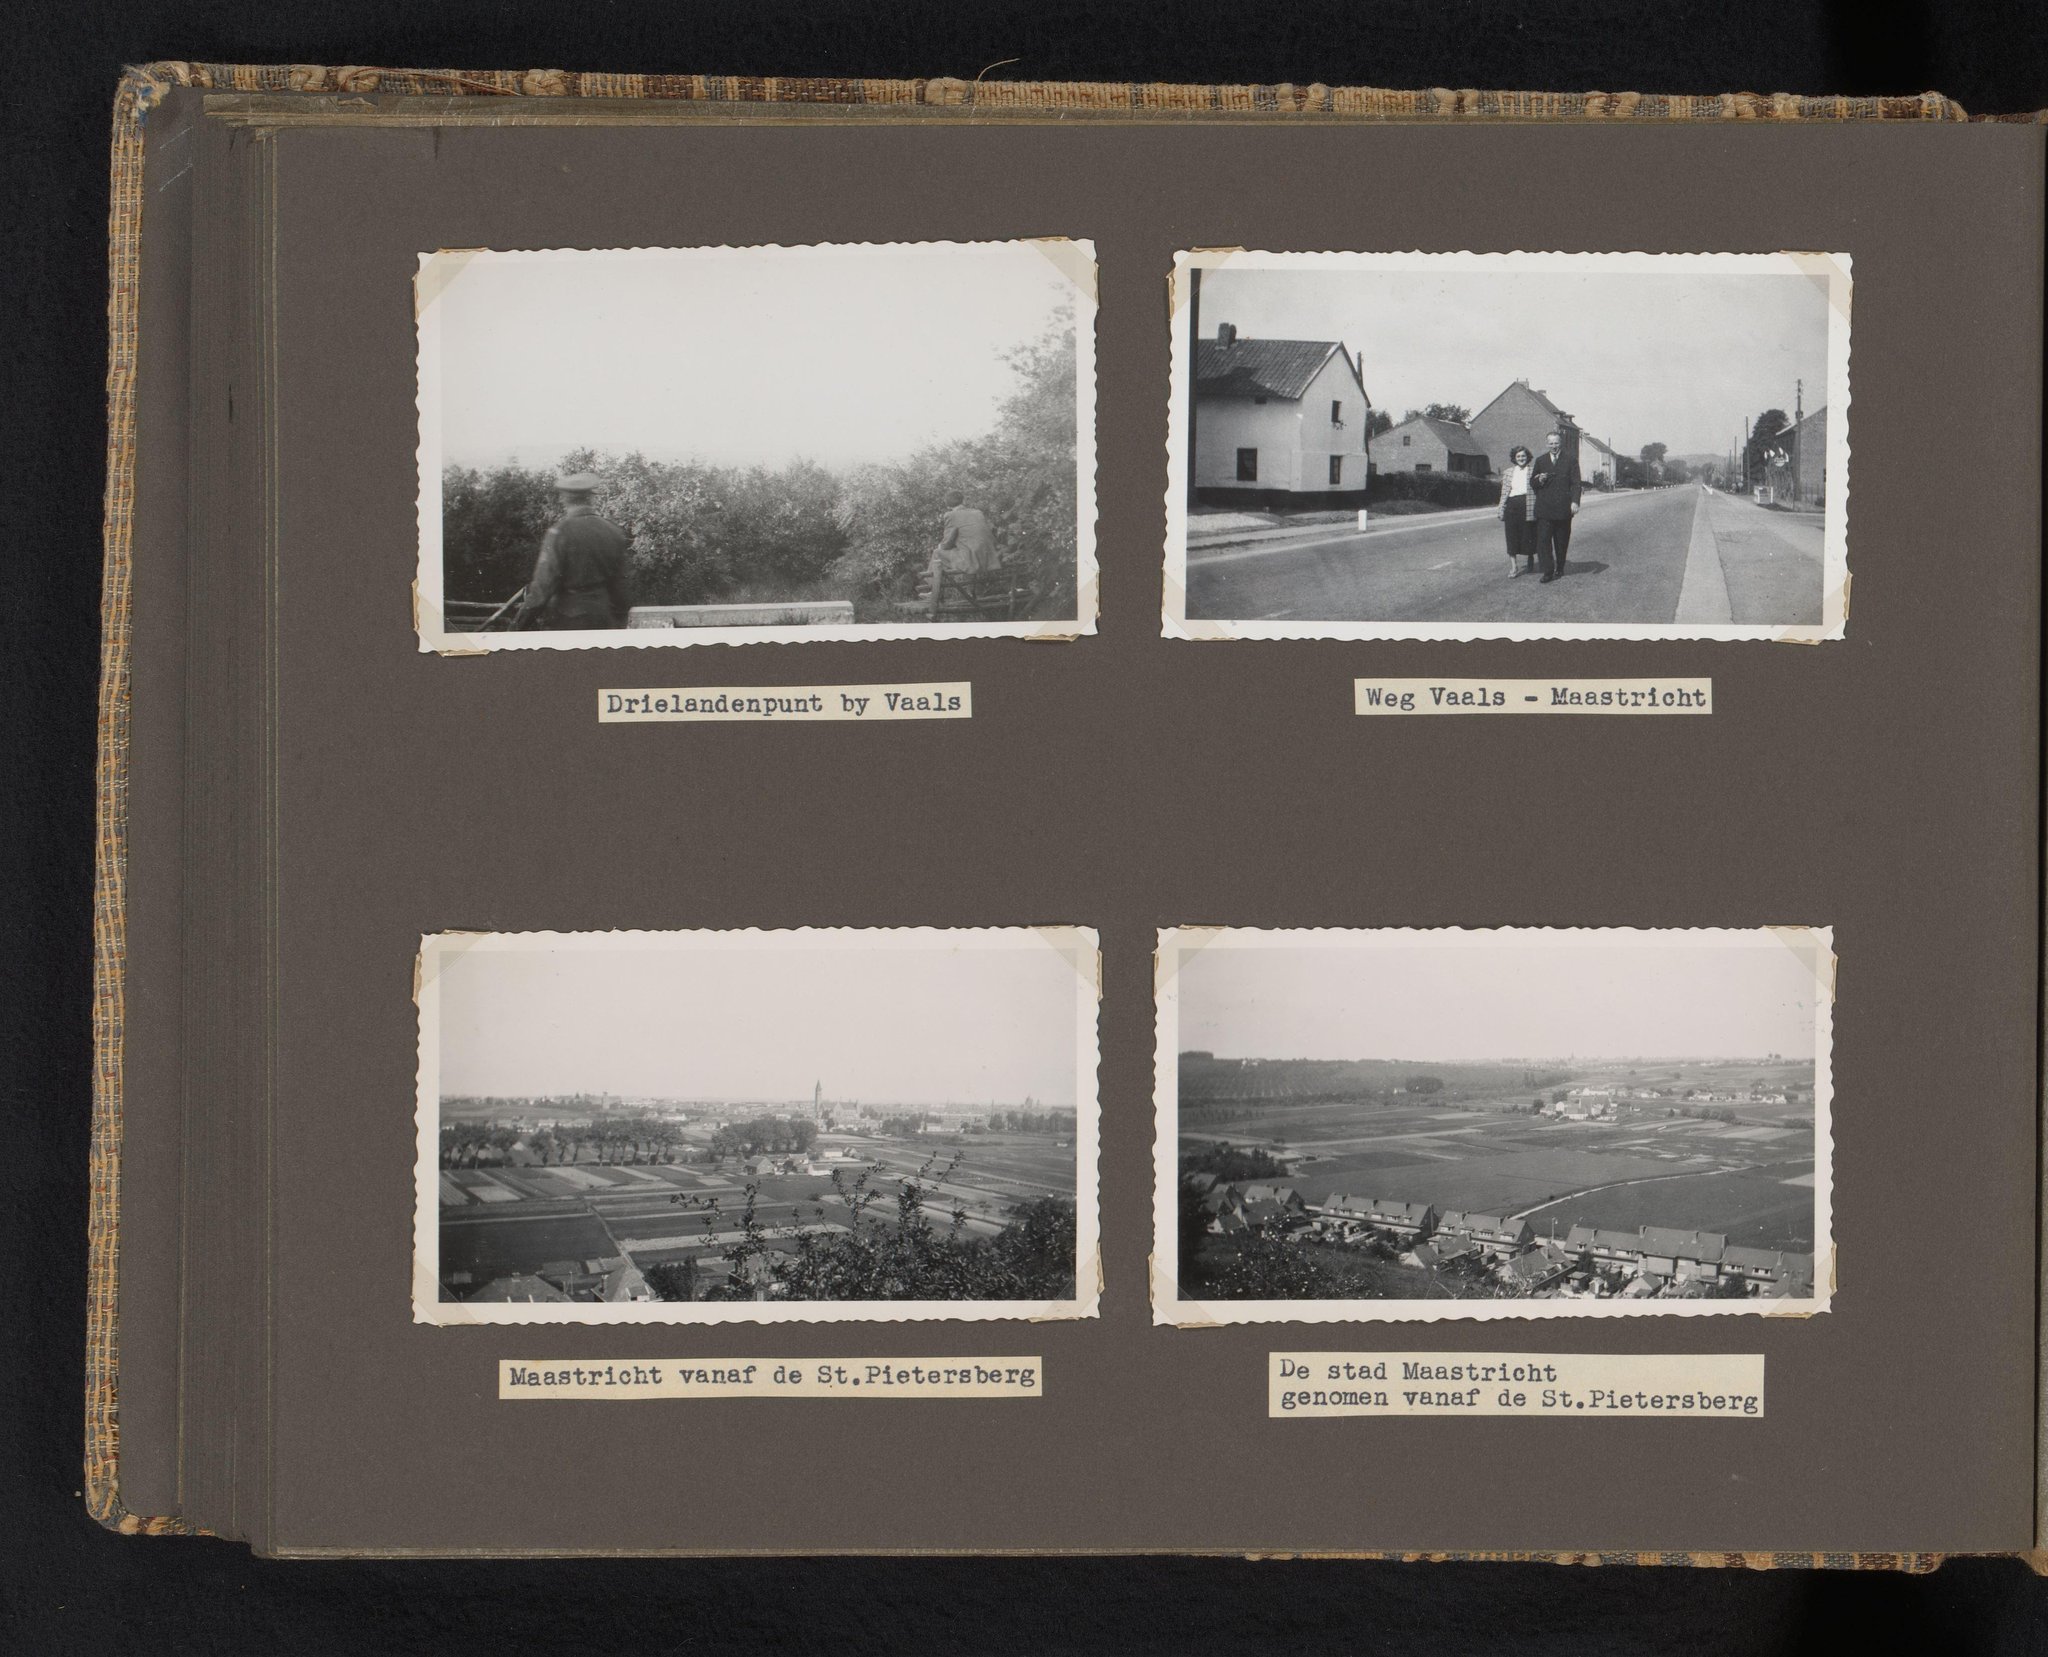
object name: photograph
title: Vaals en Maastricht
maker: Anonymous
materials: paper, photographic support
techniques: gelatin silver print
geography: netherlands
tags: the family travelling, on holiday, outing, pleasure trip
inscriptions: inscription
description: Albumblad met vier foto's bij Vaals en van Maastricht gezien vanaf de Sint-Pietersberg. Onder de foto's uitgeknipte papiertjes met getypte opschriften. Onderdeel van het eerste fotoalbum met foto's van de twee fietstochten van vader en zoon door Nederland in september 1939 en juli 1940 en een autotrip met het gezin door Nederland, België en Luxemburg in juni 1949.